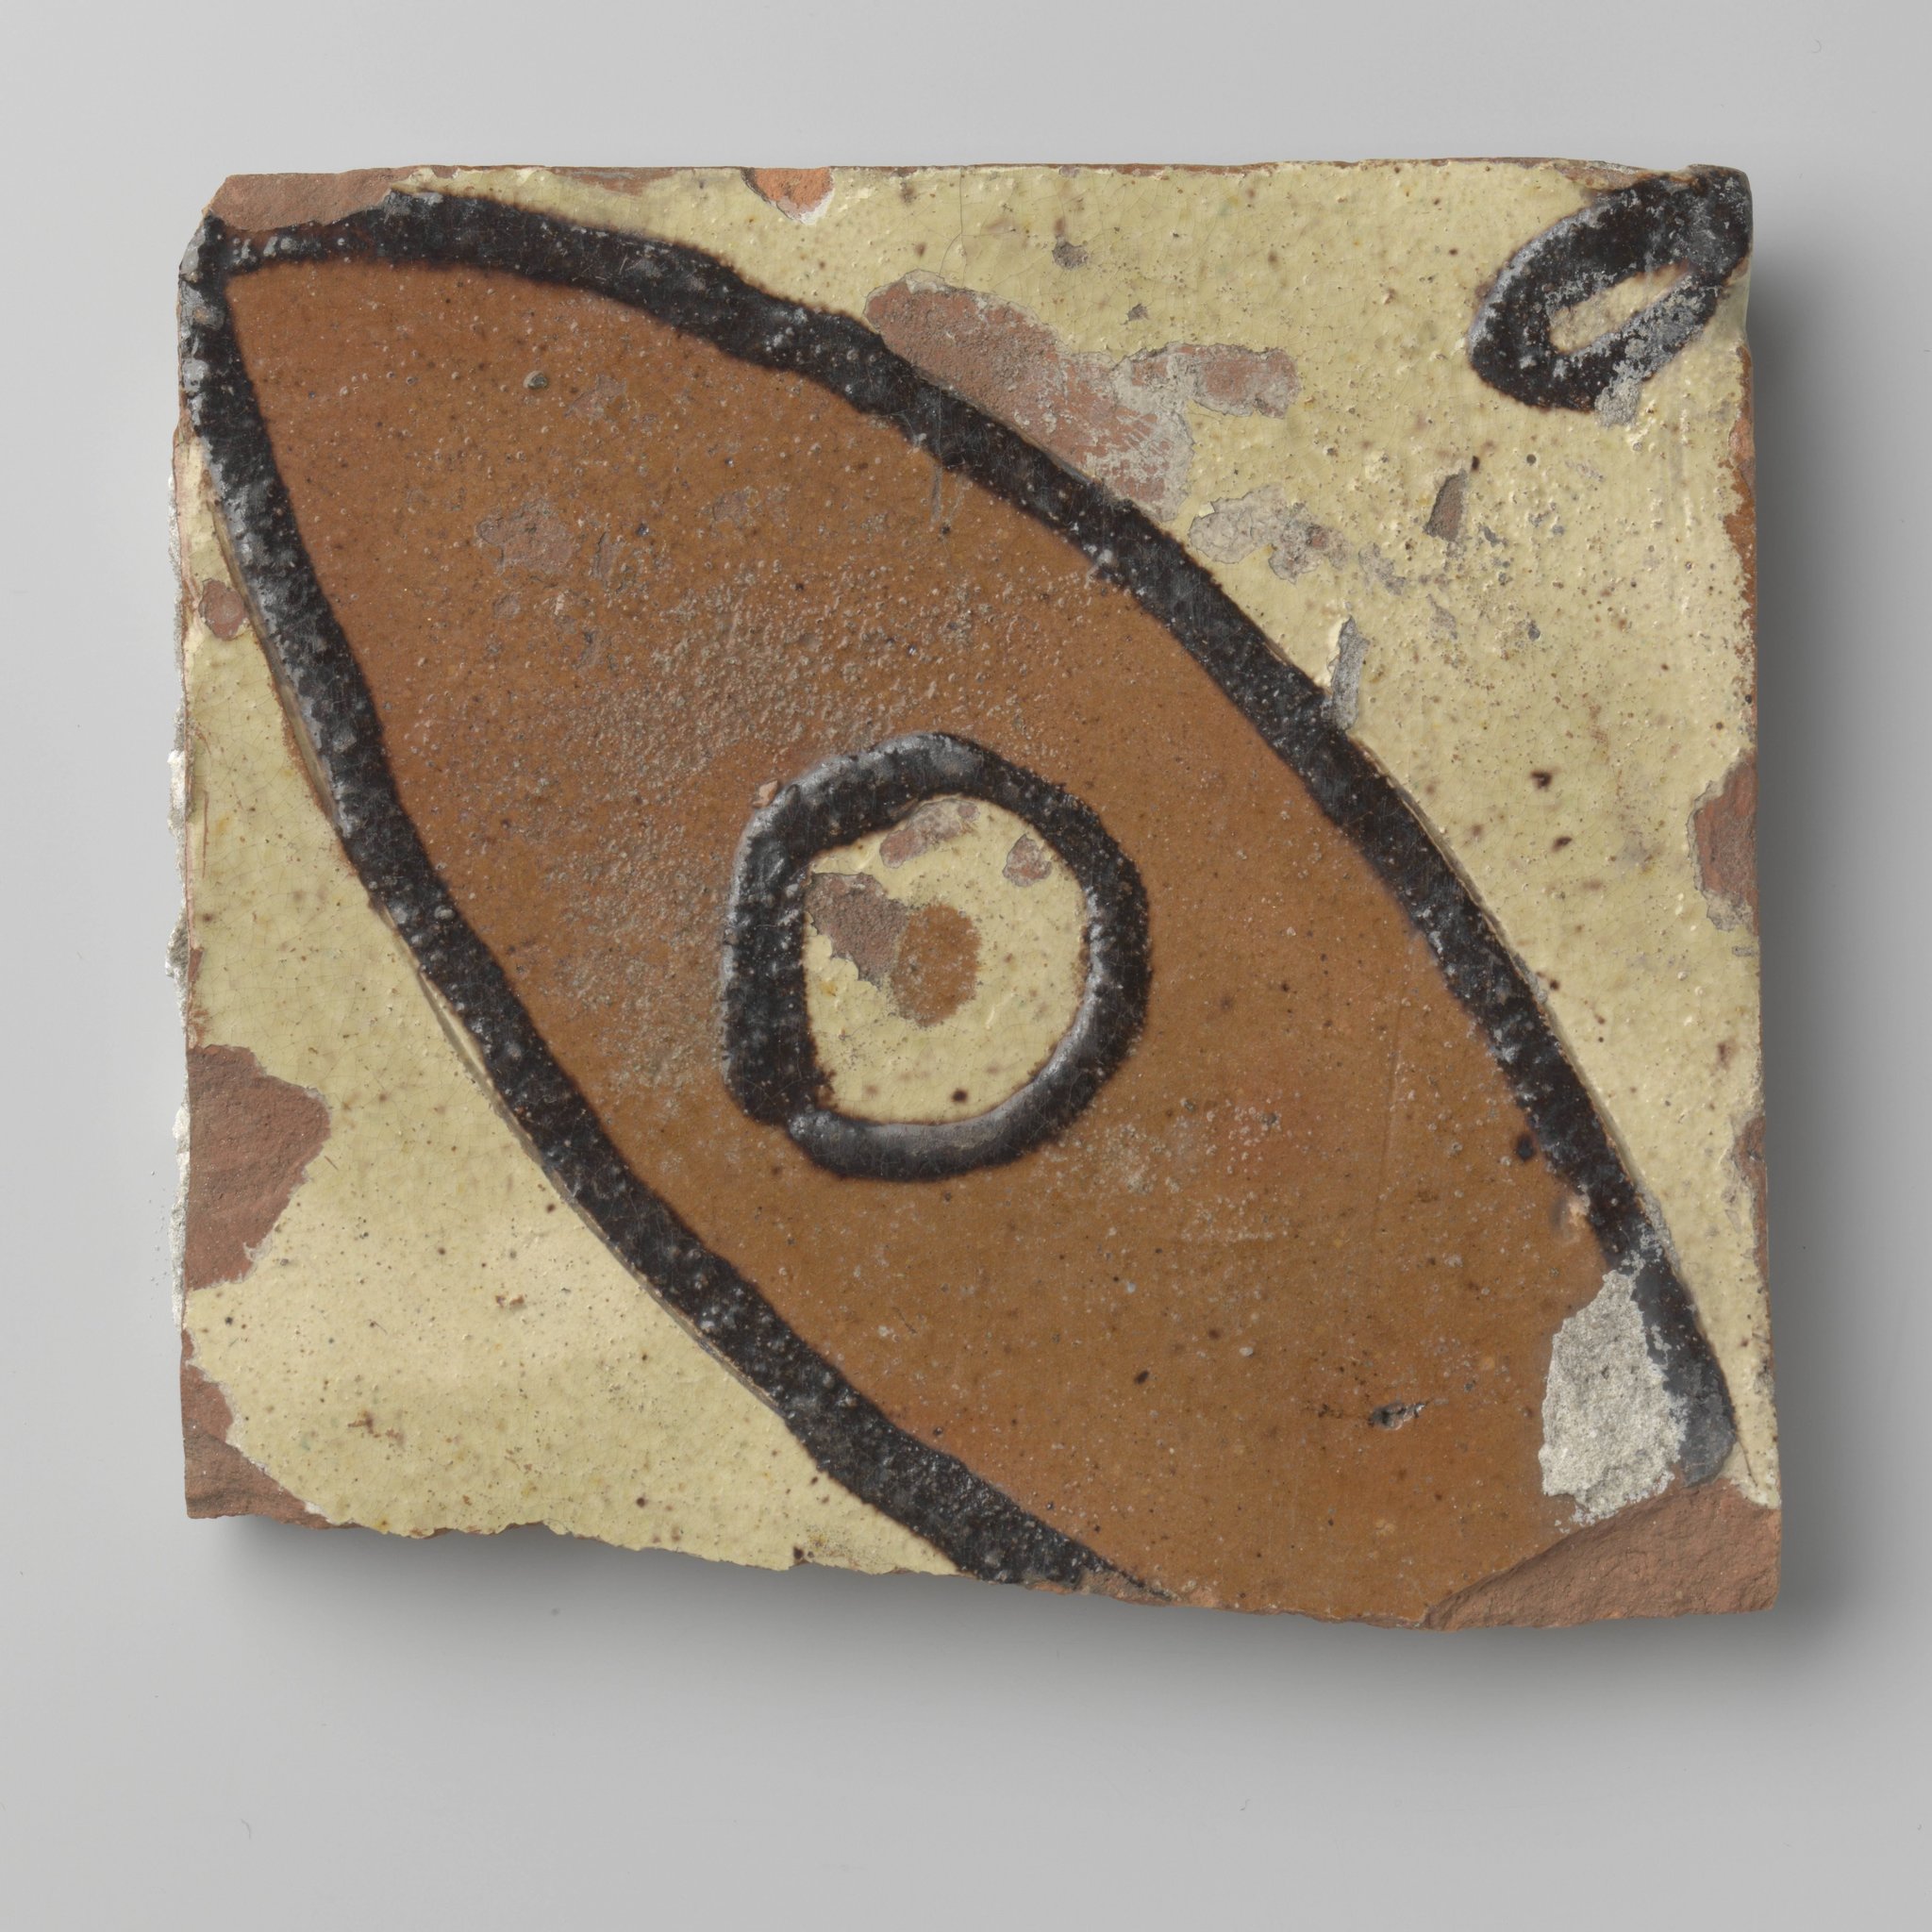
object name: tile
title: Tegel met ovaal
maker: Anonymous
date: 1700-1800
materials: earthenware, glaze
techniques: slip technique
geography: limburg